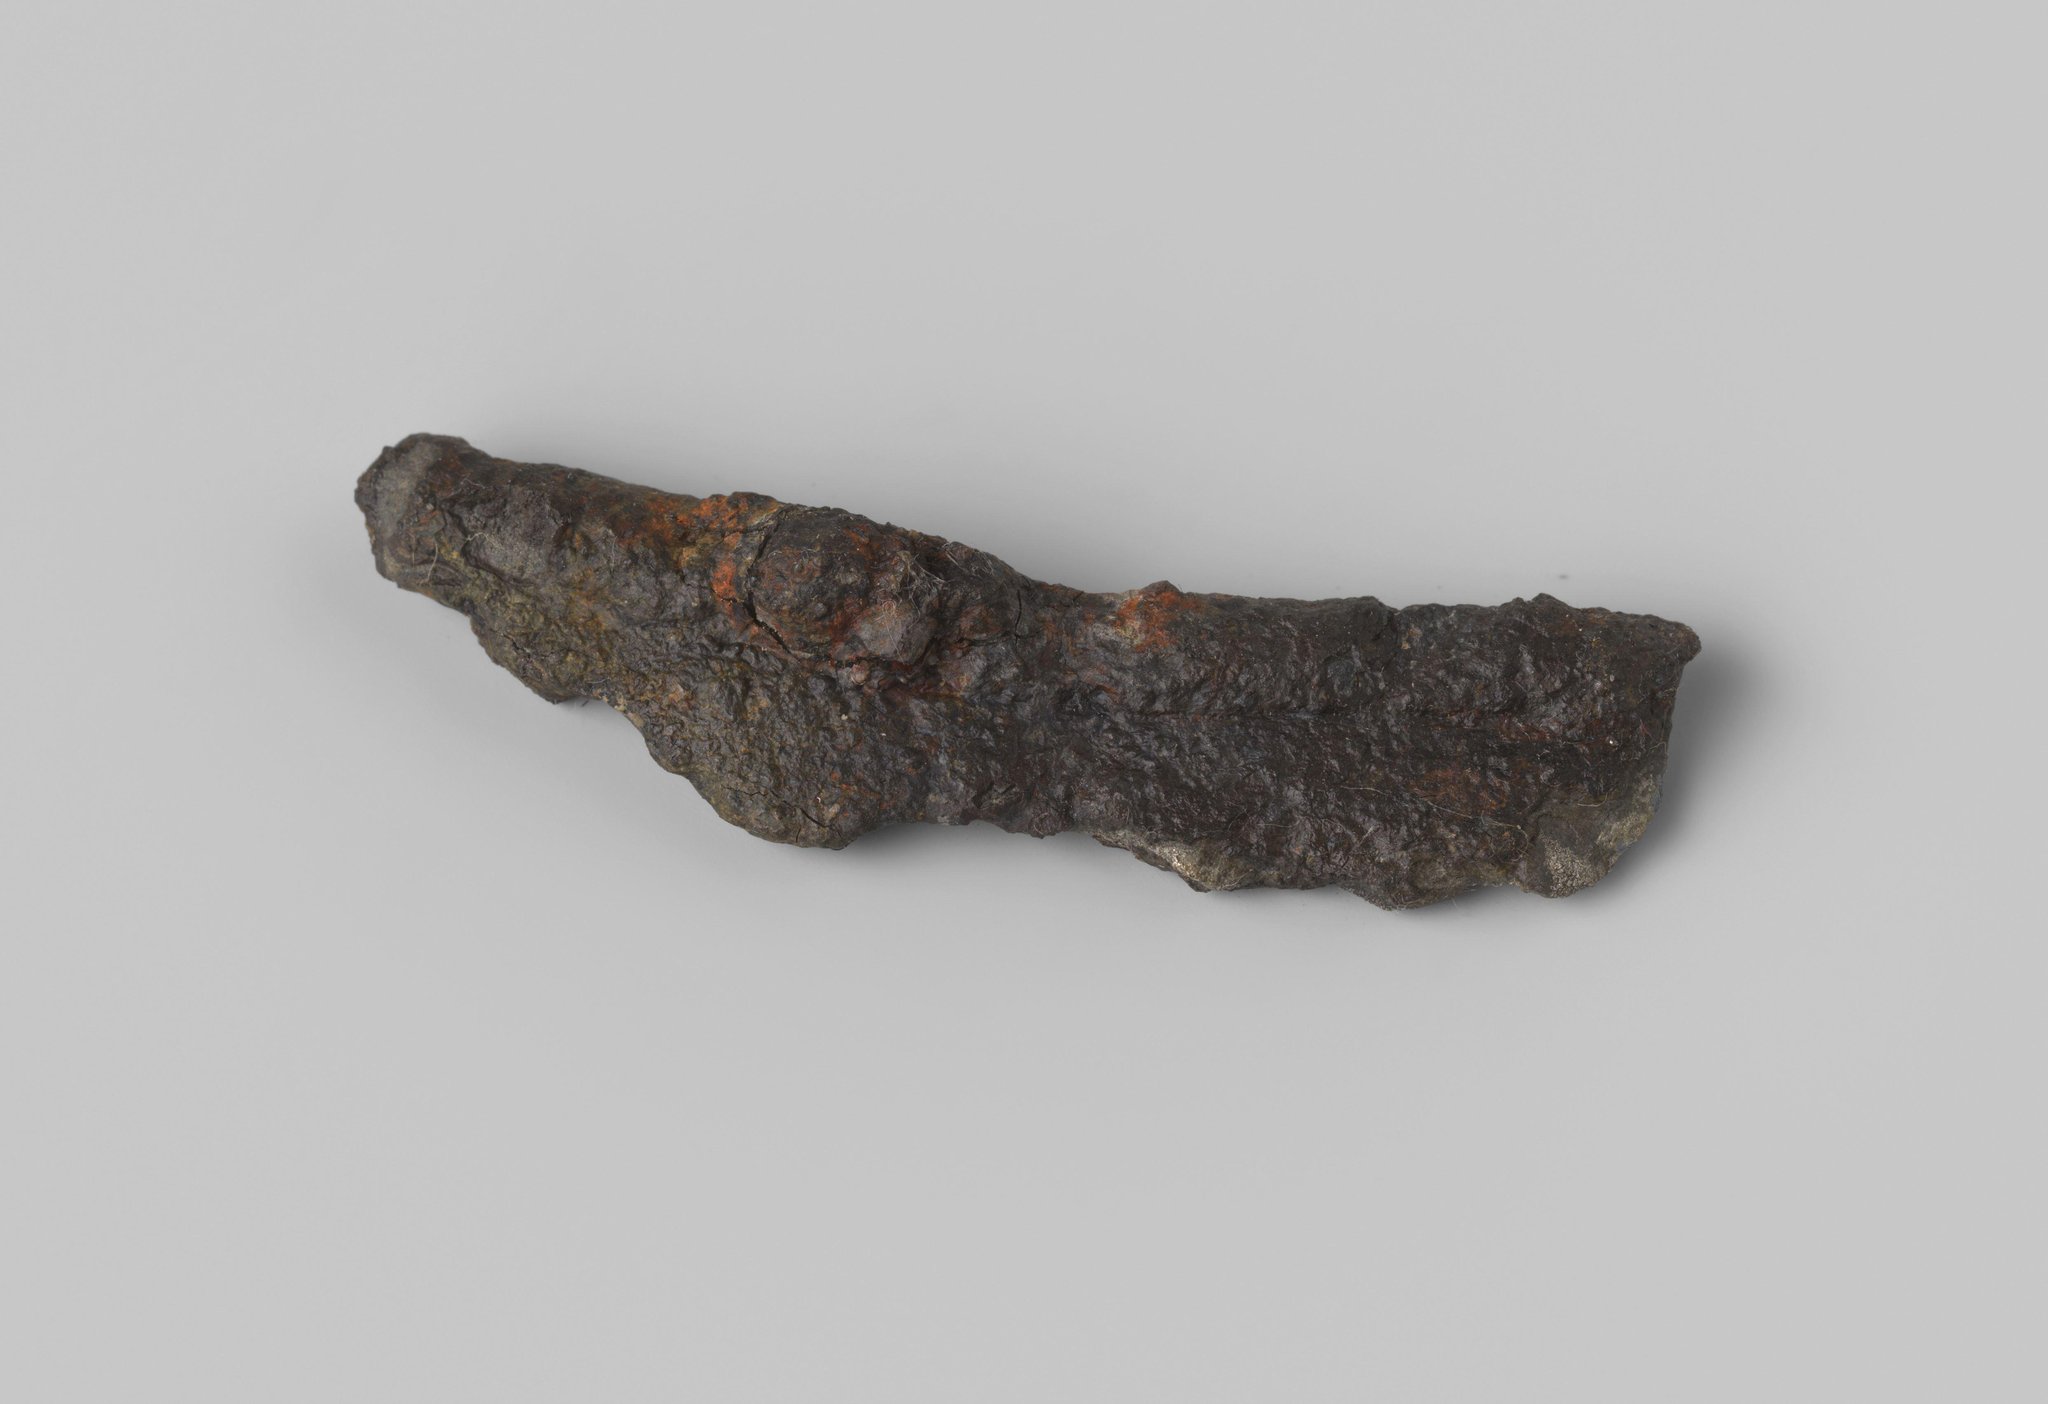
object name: plate dish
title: Fragment bord uit het wrak van de Oost-Indiëvaarder Hollandia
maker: Anonymous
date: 1700-1743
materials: tin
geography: netherlands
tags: verenigde oostindische compagnie, hollandia (schip), annet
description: Plate, fragm of rim, id. NG 1980-27H2288, corroded.